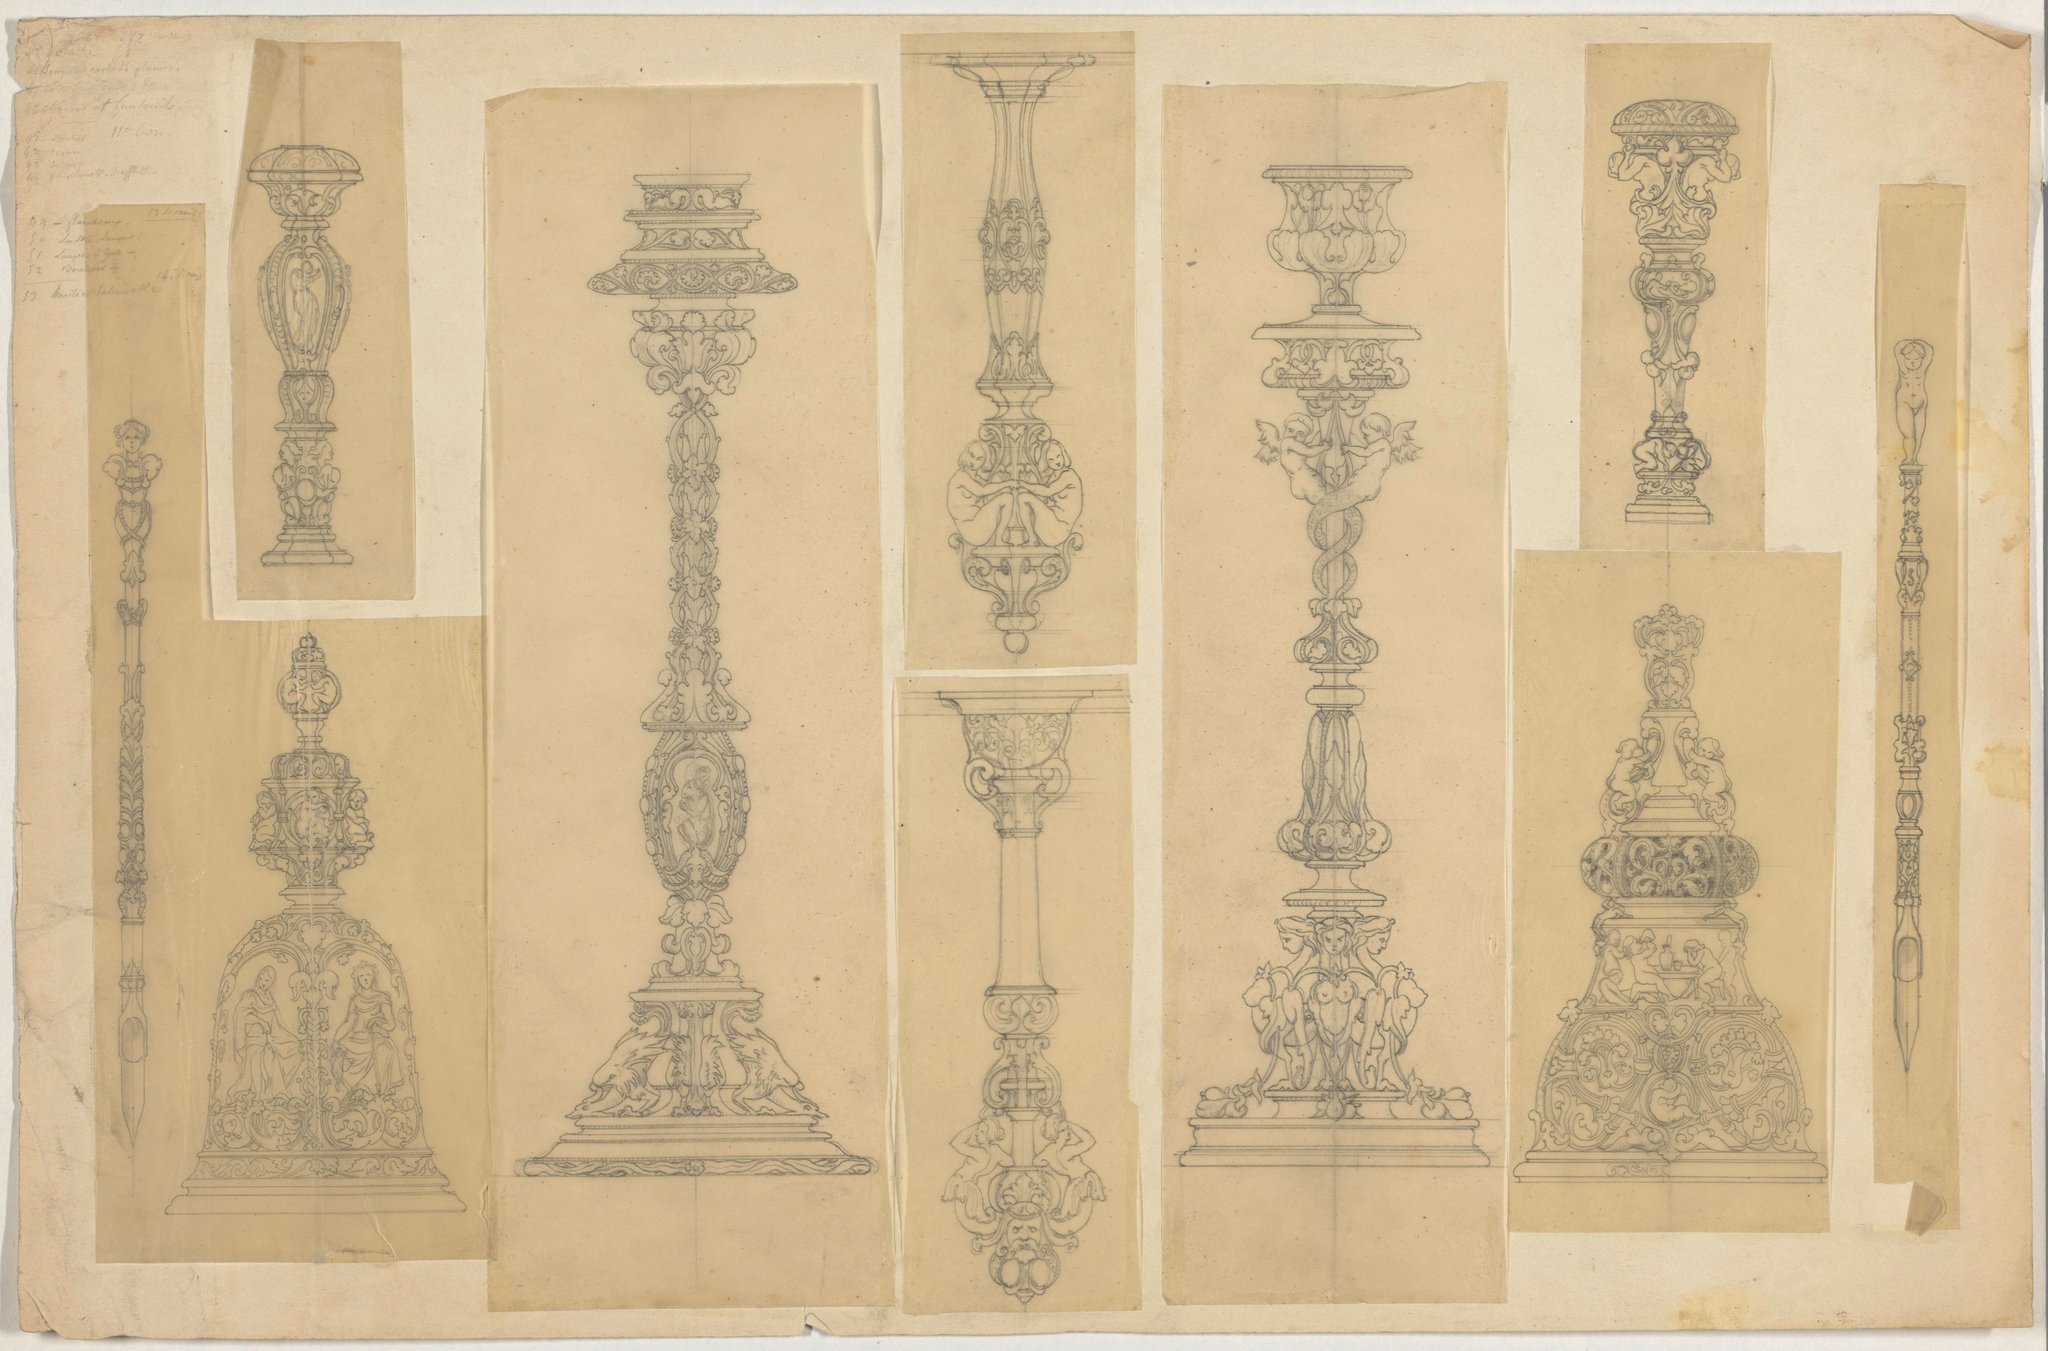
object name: design drawing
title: Ontwerpen voor diverse bronzen voorwerpen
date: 1830-1850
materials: graphite, paper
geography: paris